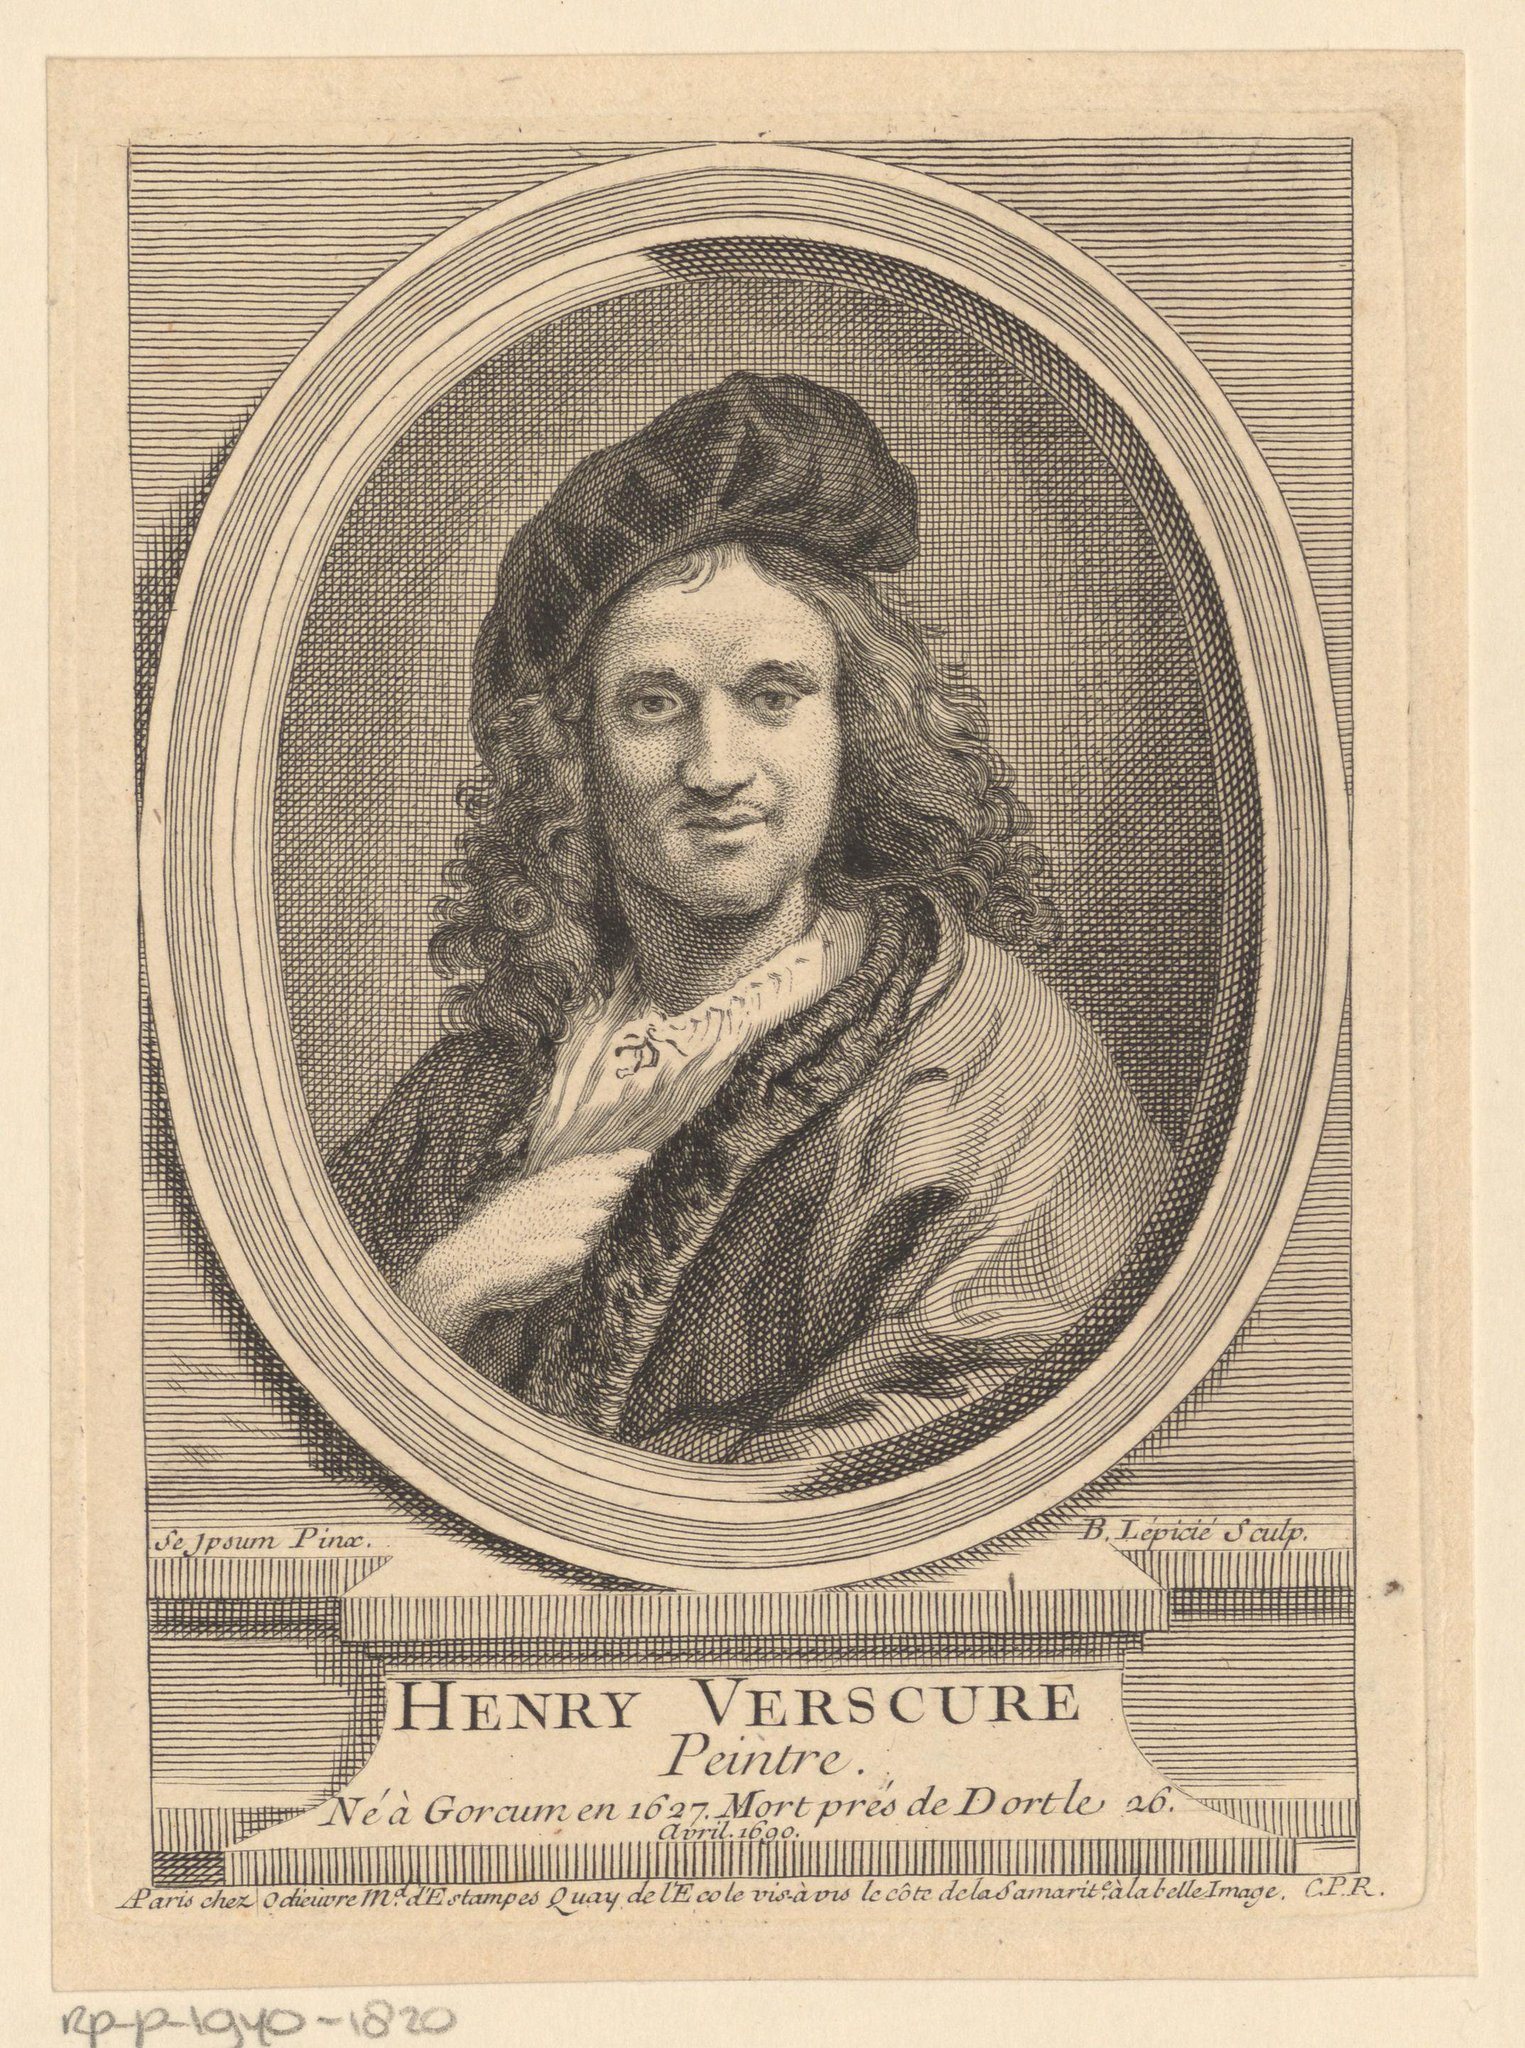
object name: print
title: Portret van Hendrik Verschuring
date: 1708-1755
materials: paper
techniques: engraving, etching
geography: france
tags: dordrecht, print maker, draughtsman, hendrik verschuring, historical persons, portrait, self-portrait of painter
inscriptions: collector's mark: Lugt 2760, collector's mark: Lugt 2228